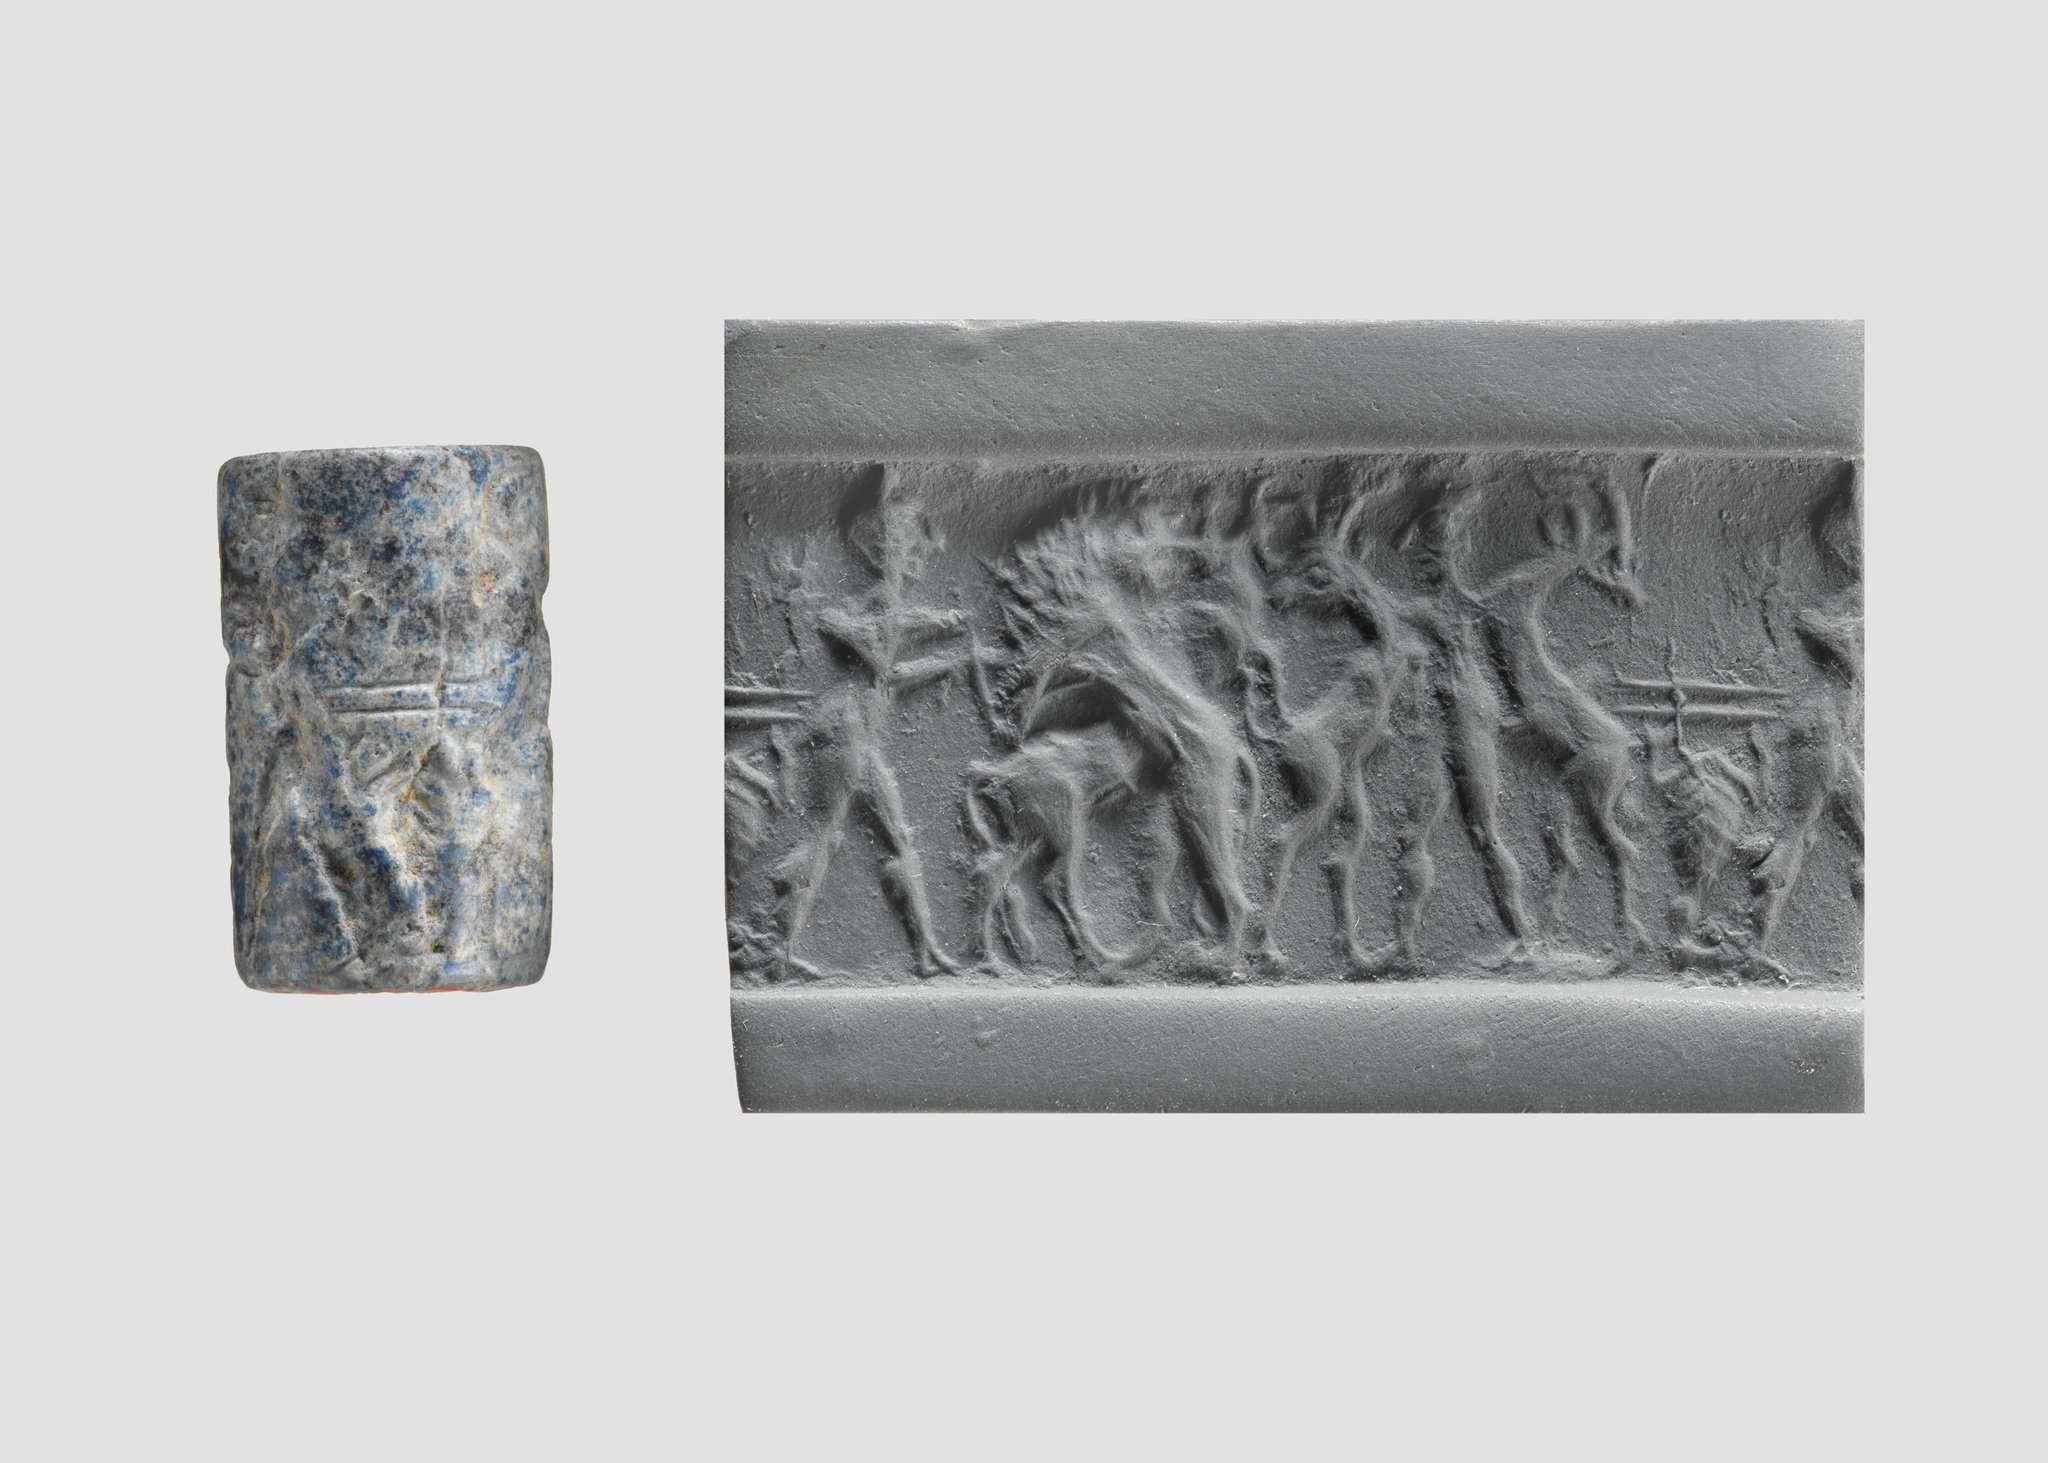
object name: cylinder seal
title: Cylinder seal and modern impression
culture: sumerian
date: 2600-2500 BCE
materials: lapis lazuli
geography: mesopotamia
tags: animals,men